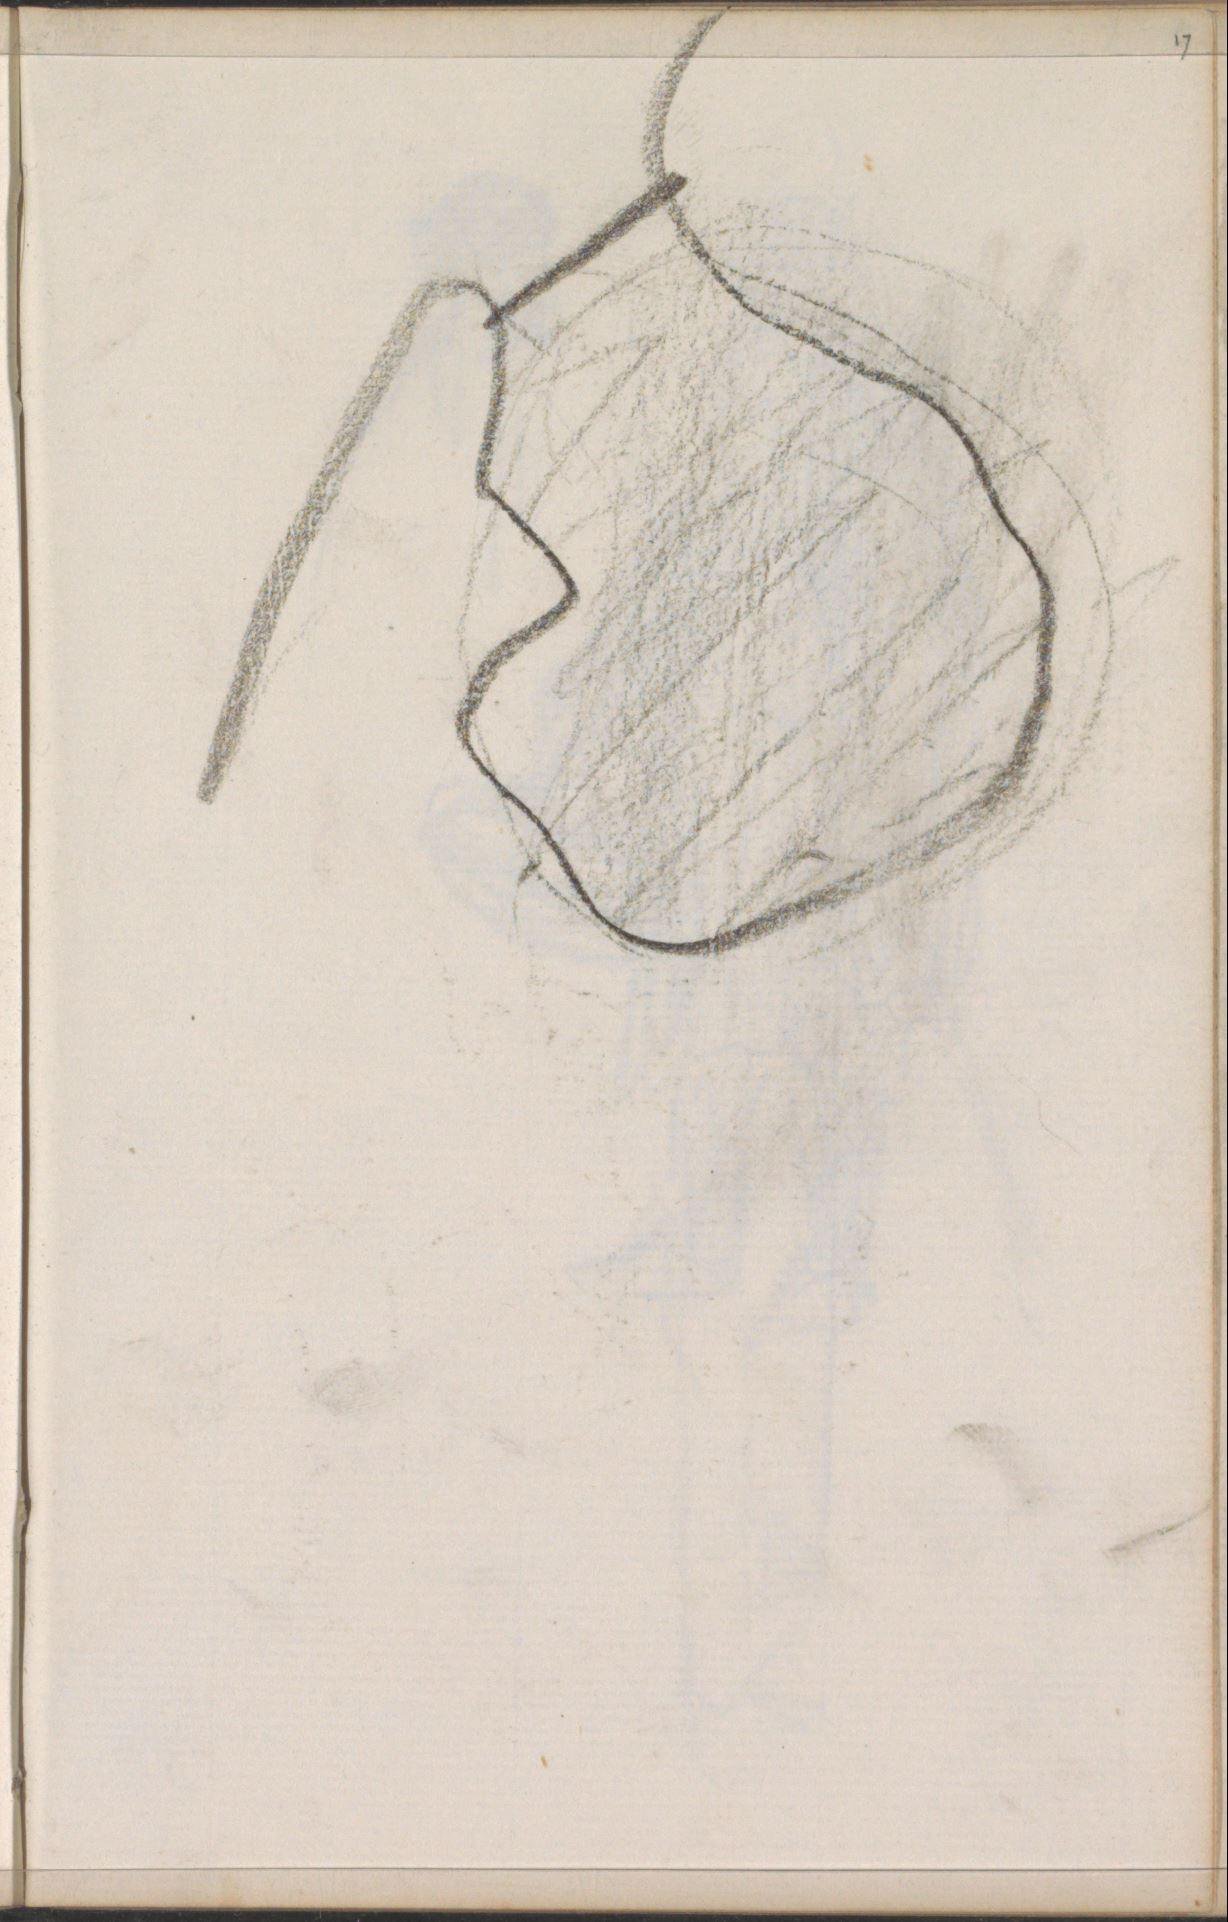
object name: sketchbook leaf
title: Studie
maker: marius bauer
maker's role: draughtsman, print maker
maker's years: 1867-1932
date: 1899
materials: chalk, paper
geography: turkey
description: Pagina 17 uit een schetsboek met 42 bladen.